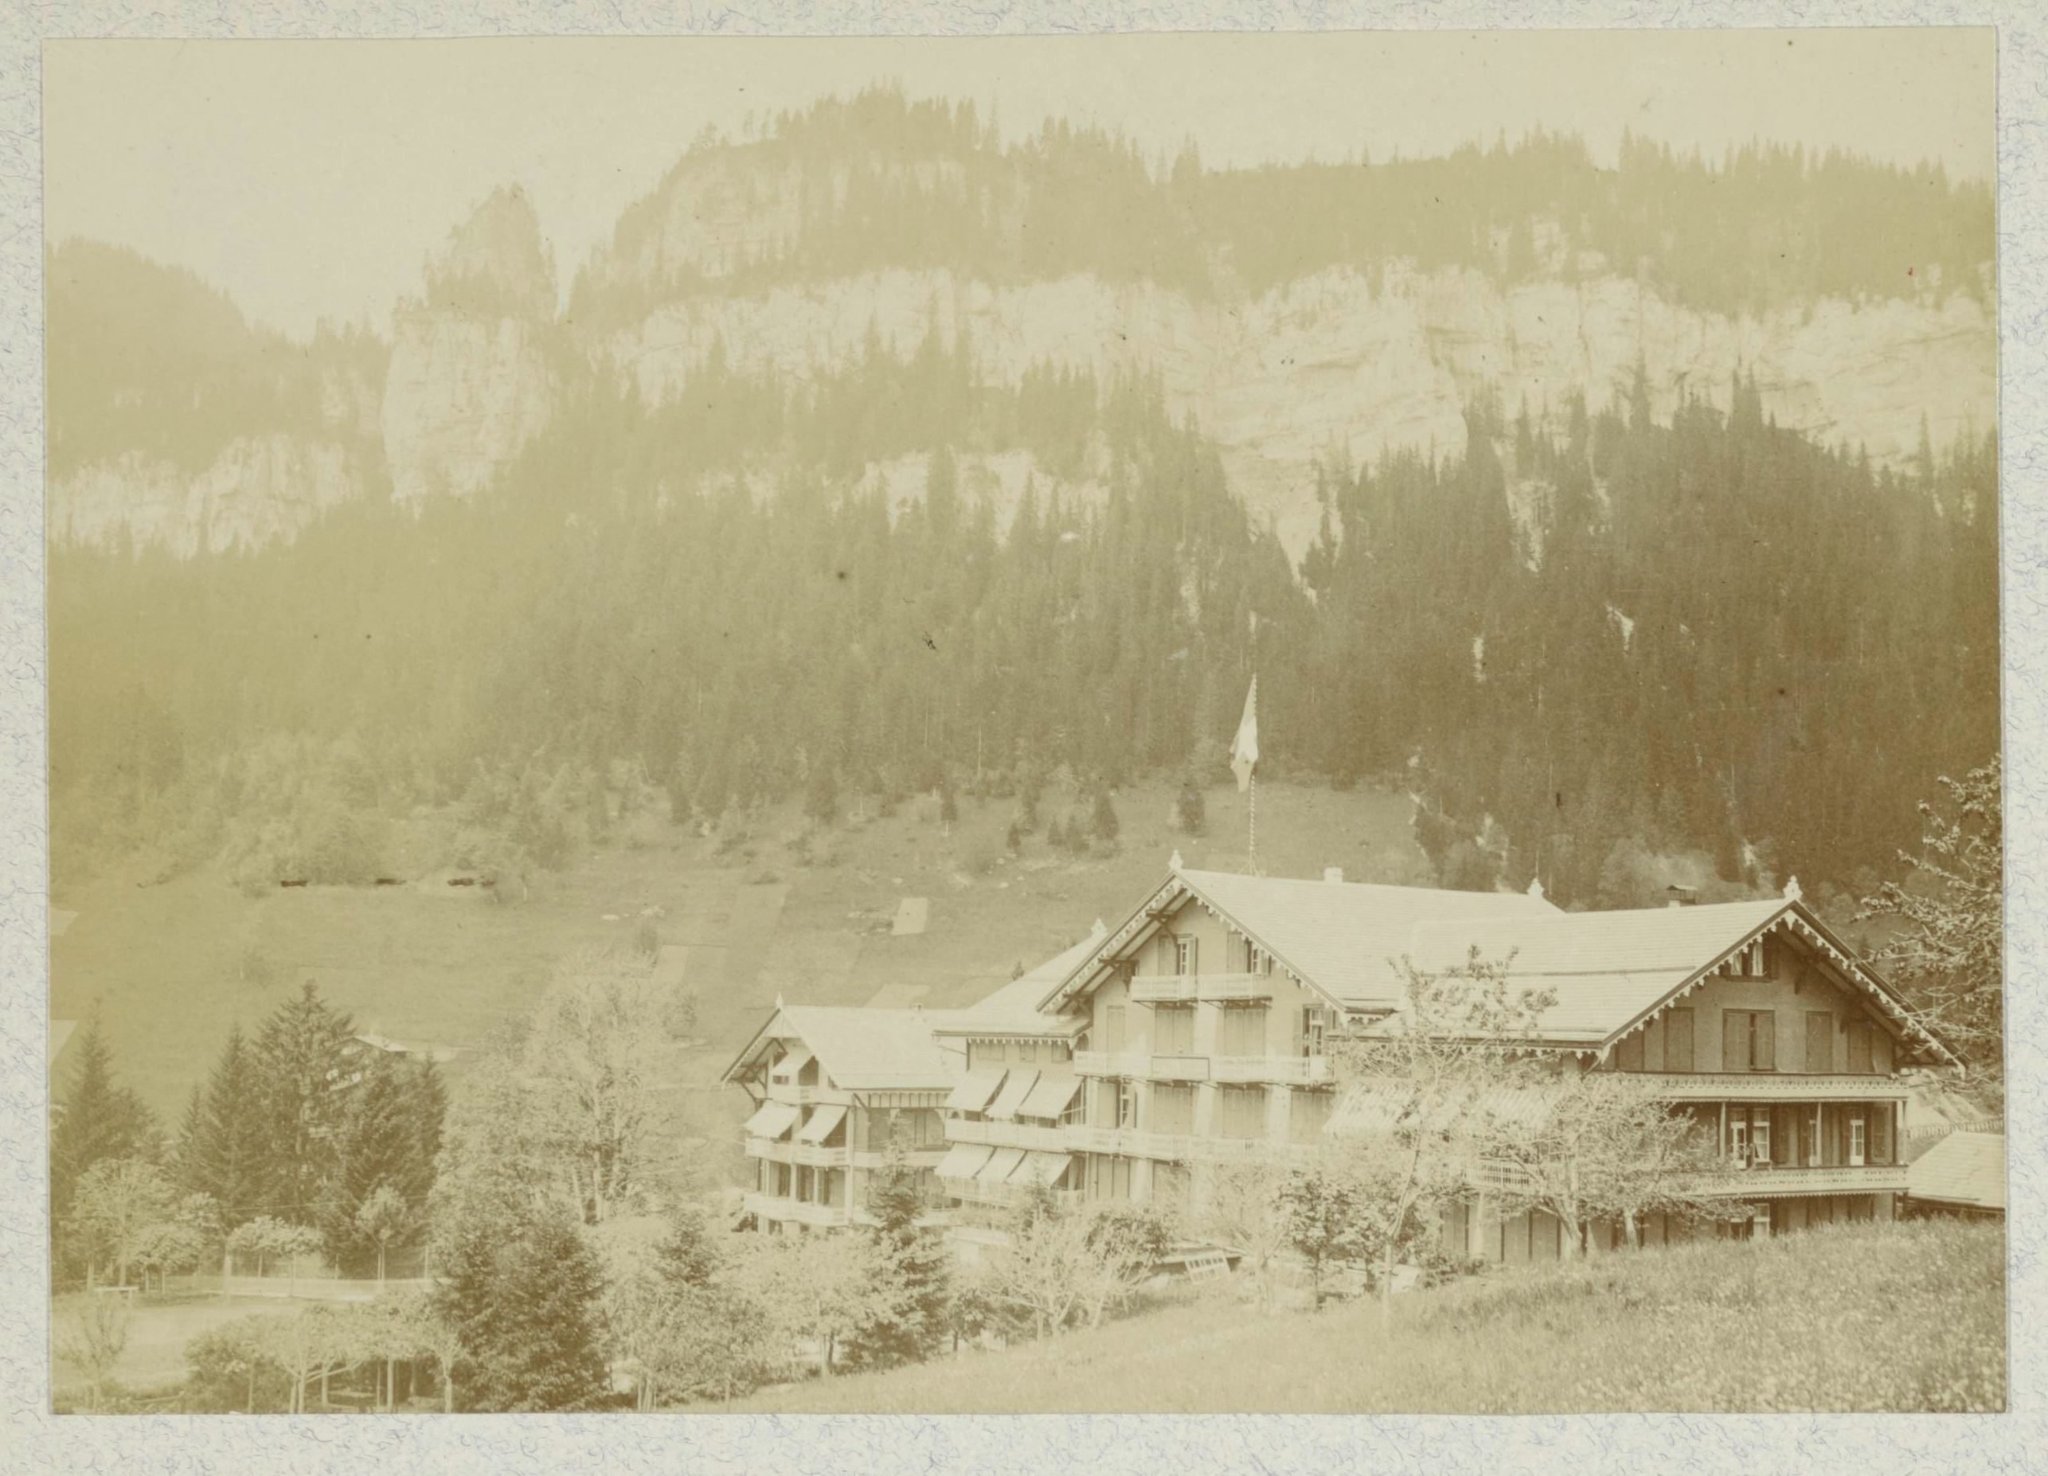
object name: photograph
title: Vakantie in Zwitserland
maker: andries augustus boom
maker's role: amateurfotograaf, handelaar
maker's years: 1878-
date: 1899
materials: photographic support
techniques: photography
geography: switzerland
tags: andries augustus boom, switzerland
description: Vakantie in Zwitserland. Onderdeel van het fotoalbum van de familie Boom-Gonggrijp in Suriname en Curaçao.